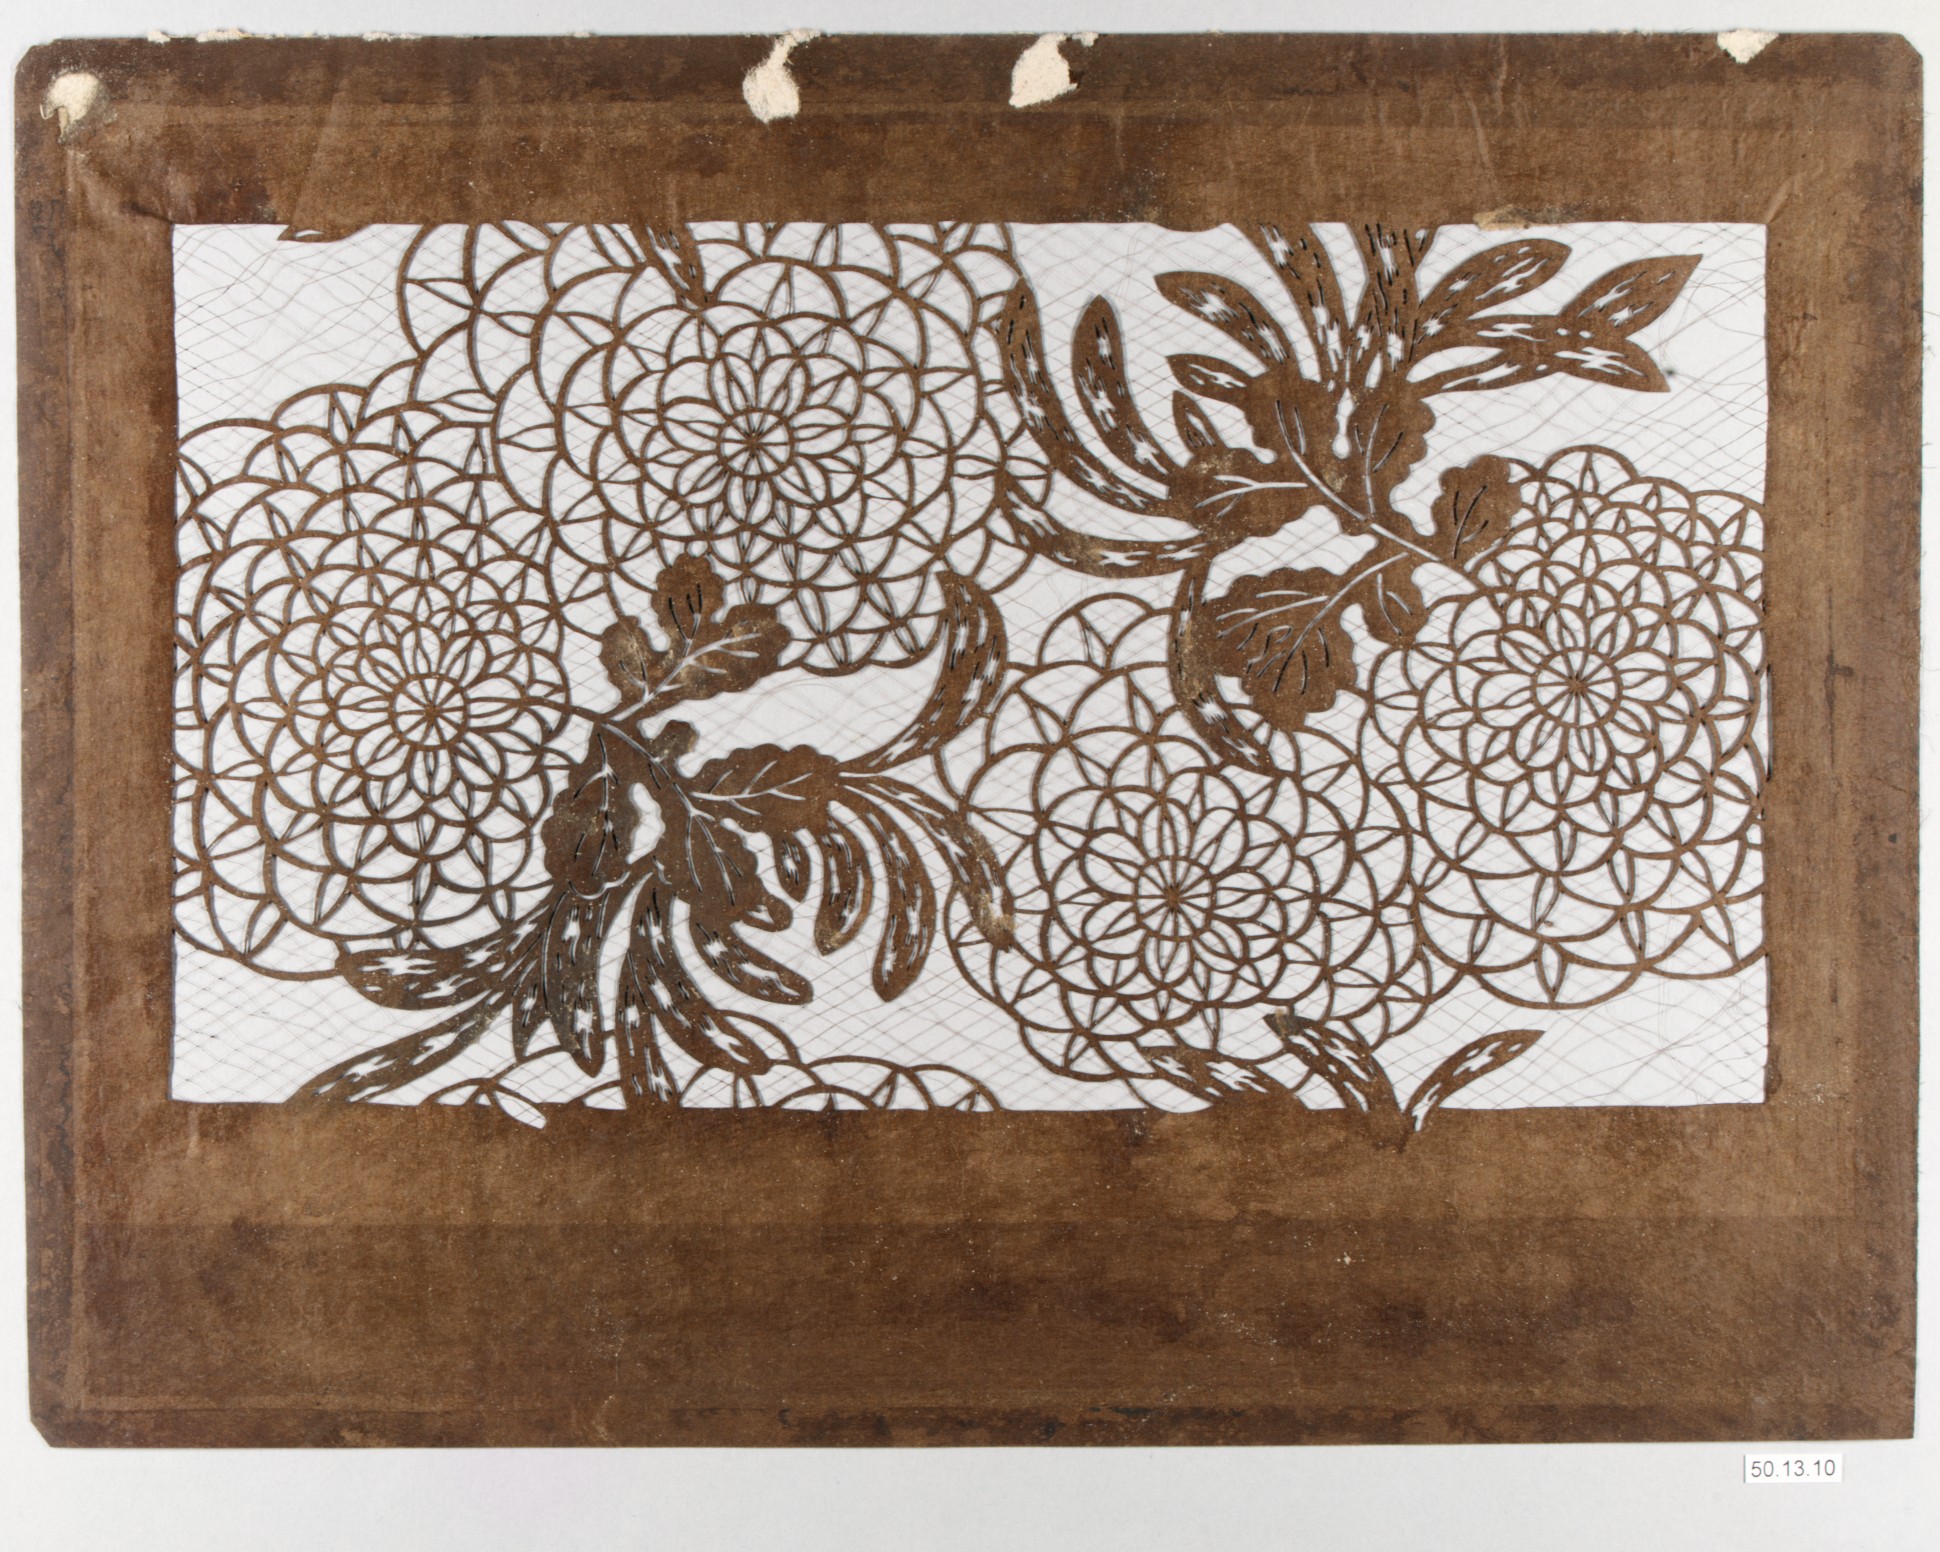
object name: stencil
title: Chrysanthemums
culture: japanese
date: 1801-1900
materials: paper, silk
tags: flowers,leaves